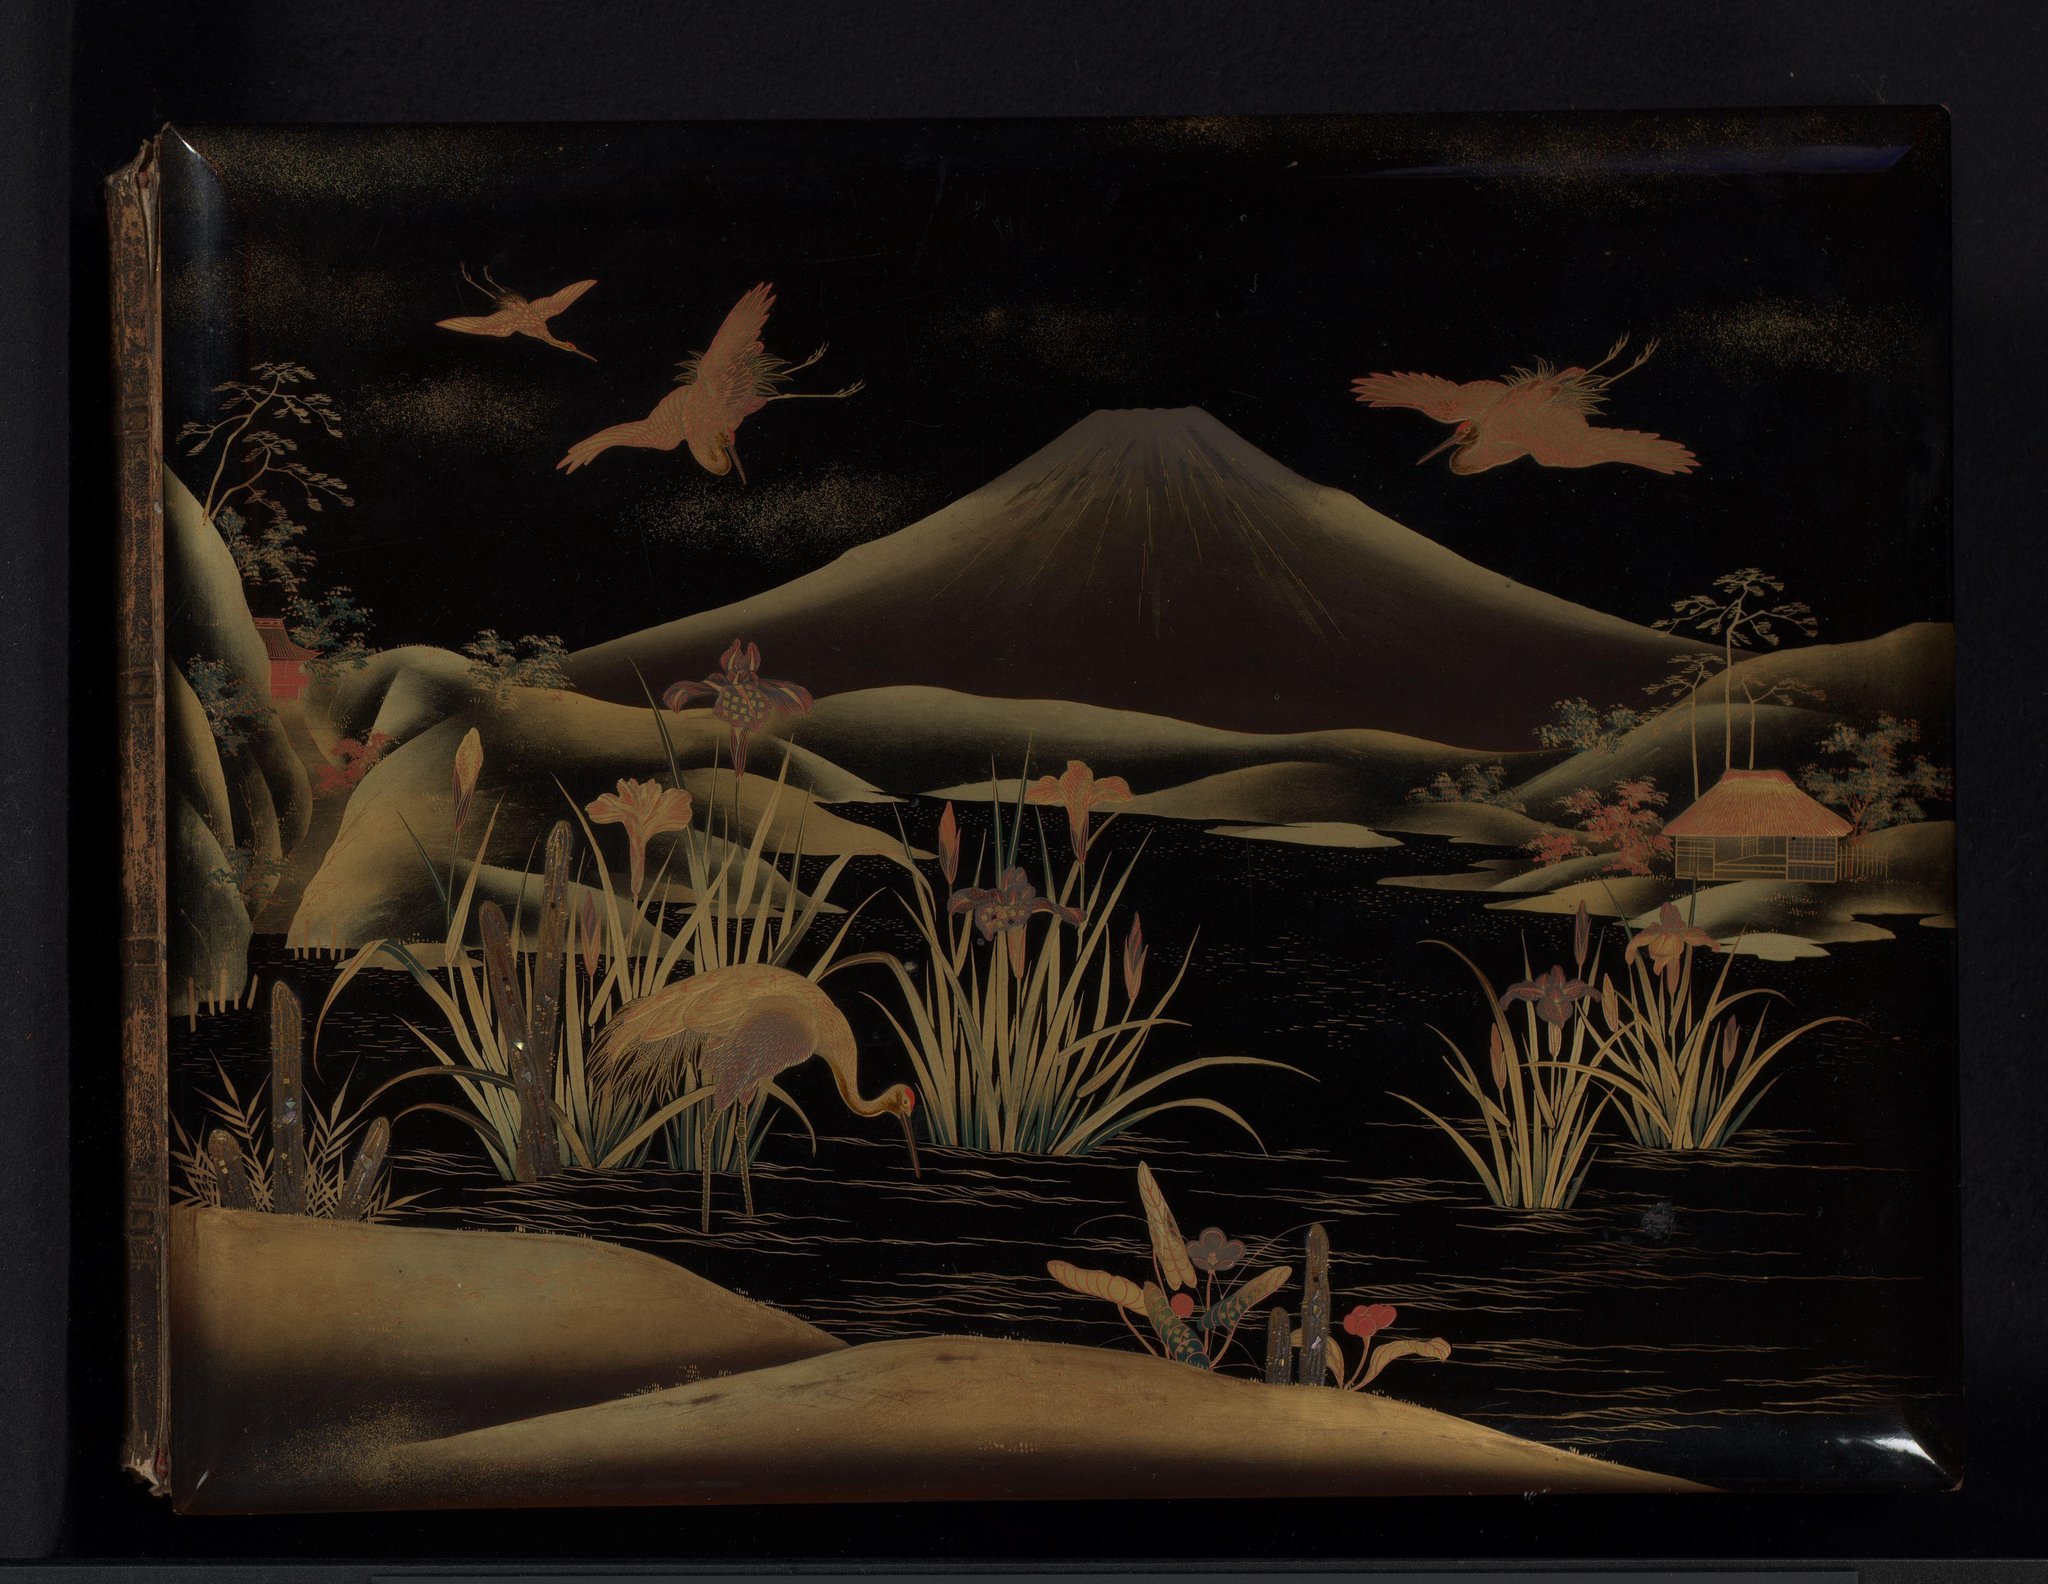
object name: photograph album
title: Fotoalbum (leeg)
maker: Anonymous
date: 1860-1900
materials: cardboard, paint, lacquer, leather, mother of pearl, paper, silk, textile, watercolor, wood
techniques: brush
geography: japan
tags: shore-birds and wading-birds: crane, temple, shrine ~ shinto, mountains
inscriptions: collector's mark: ‘DIENST/ VERSPREIDE/ RIJKSKOLLEKTIES/ (...) A 1085’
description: Fotoalbum met 18 pagina's met ofwel naast elkaar 2 gedecoreerde passe-partouts voor kabinetfoto's, ofwel 2 rijen van 3 gedecoreerde passe-partouts voor cartes-de-visite. In totaal is er in het album plaats voor 32 kabinetfoto's en 12 cartes-de-visite.